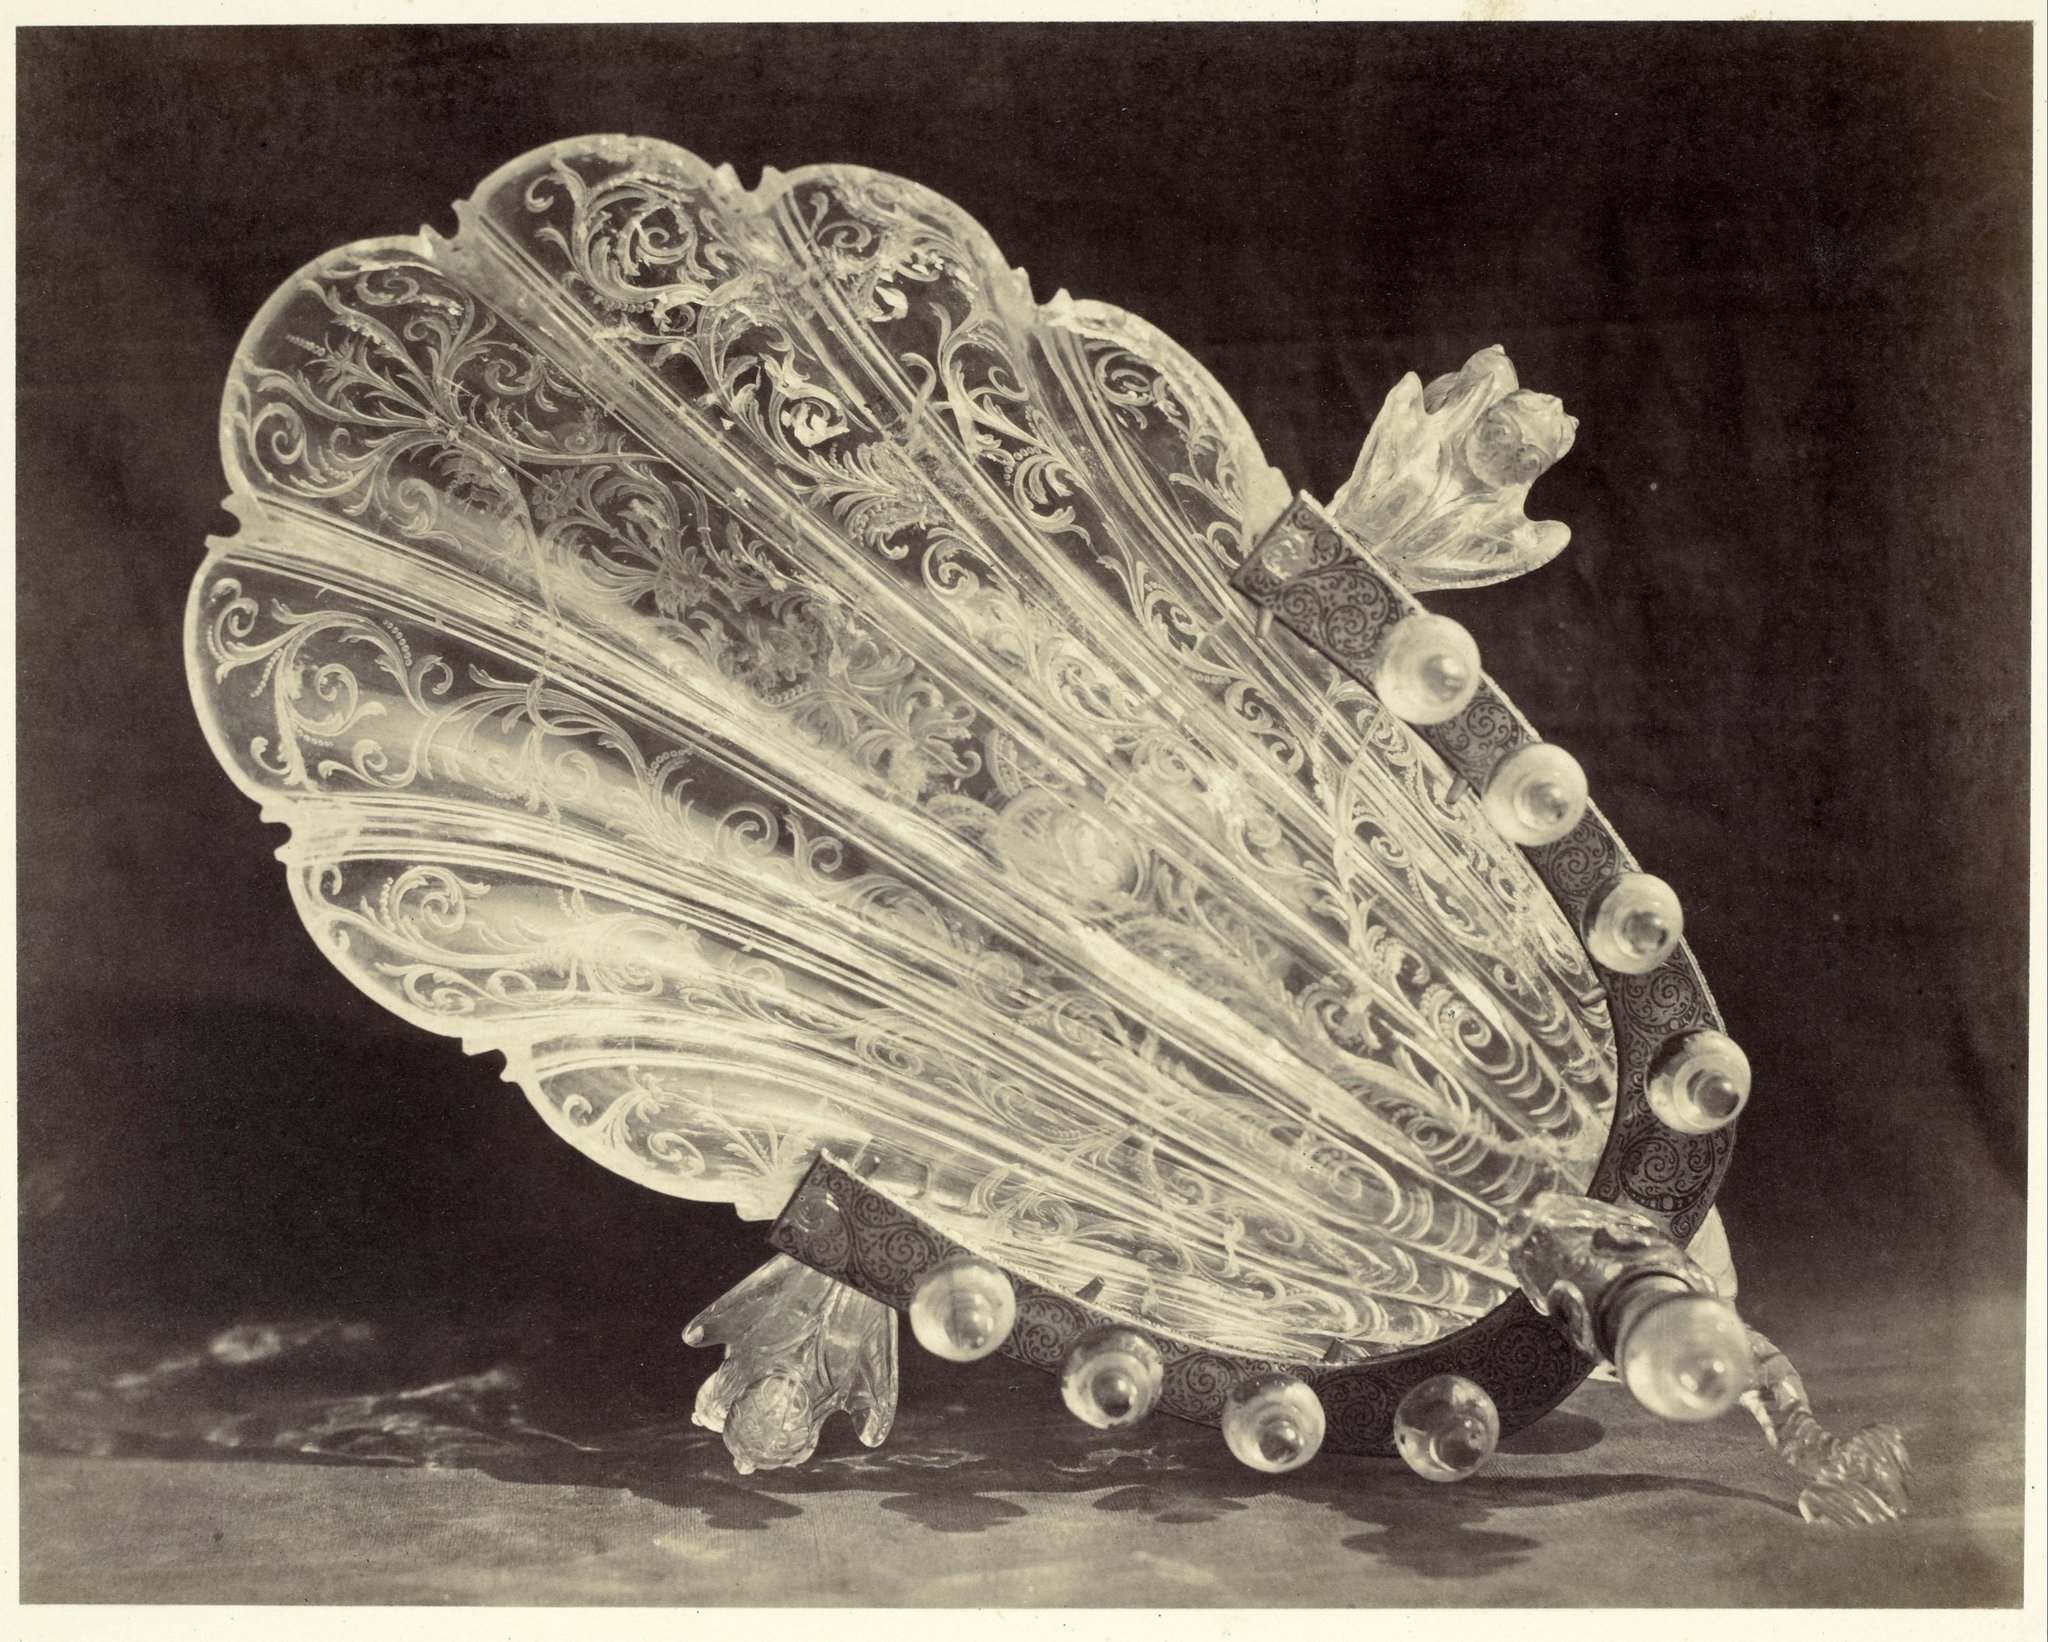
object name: photomechanical print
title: Kristallen schelpvormige schaal, uit het Louvre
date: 1866-1890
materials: paper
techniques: woodburytype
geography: louvre museum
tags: container of glass: bottle, jar, vase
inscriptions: inscription: ‘Photographed by C. Thurston Thompson.’